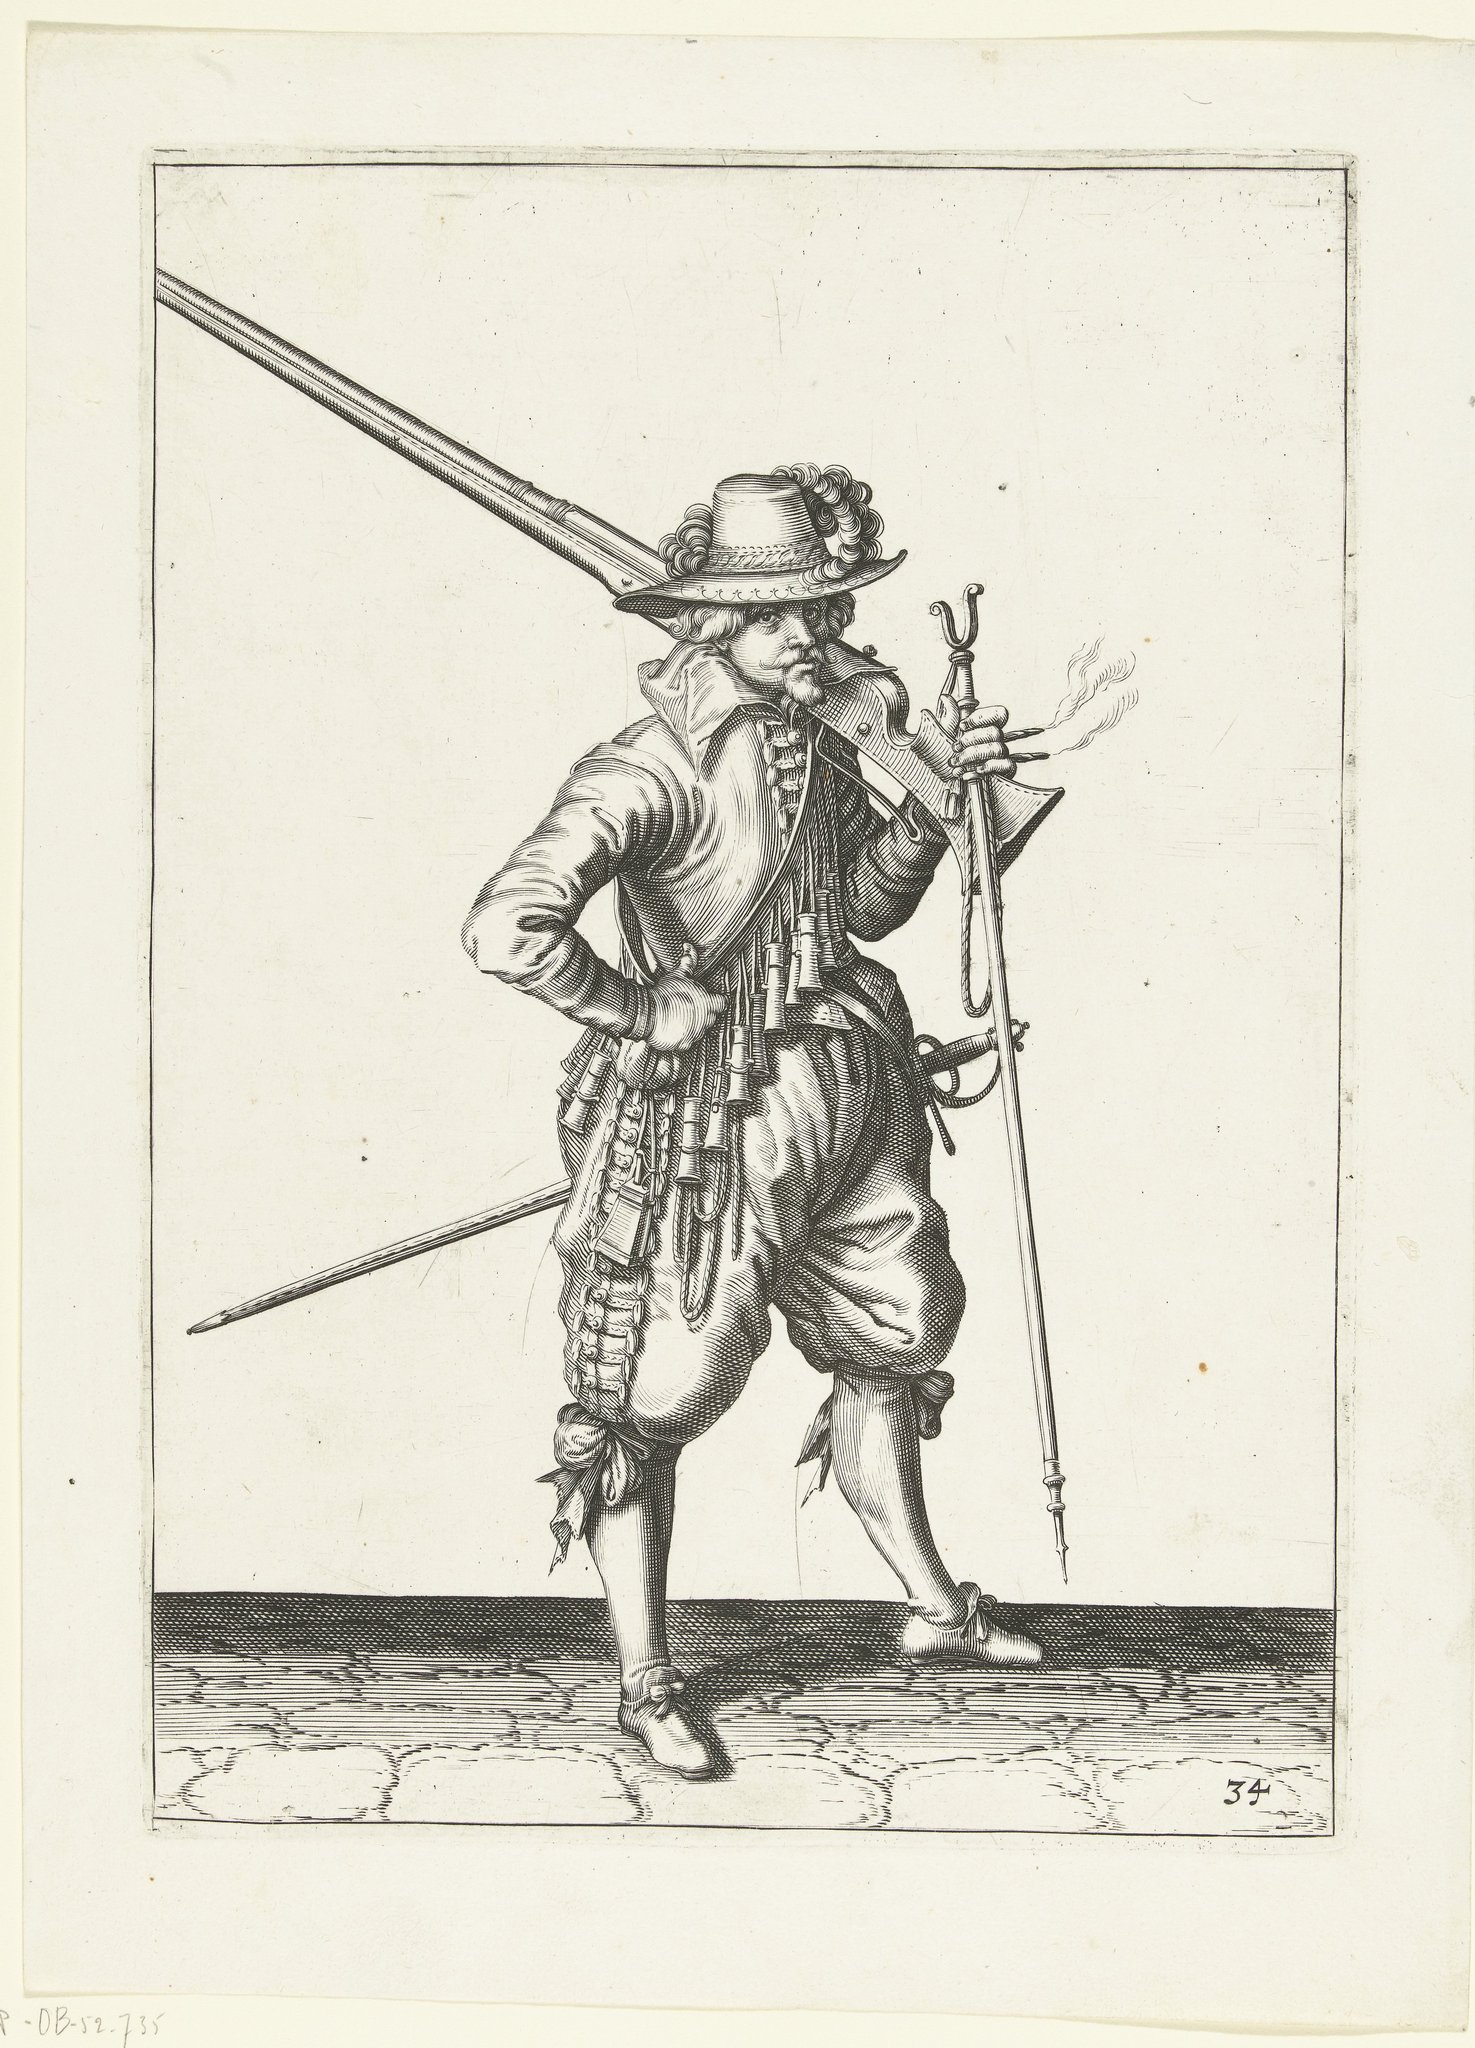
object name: print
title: Wapenhandelinghe van Roers Musquetten ende Spiessen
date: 1597-1607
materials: paper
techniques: engraving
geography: netherlands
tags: manoeuvre ~ military training, firearms: rifle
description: Een soldaat, ten voeten uit, naar rechts, met een musket (een bepaald type vuurwapen) steunend op zijn linkerschouder. In zijn linkerhand behalve de kolf van het musket ook een brandende lont en een furket (musketvork). Het gaat dus om (vrijwel) dezelfde positie als degene die op de tweede prent van de serie getoond wordt. Deze prent is onderdeel van de reeks van 43 genummerde prenten van musketiers uit de Wapenhandelinghe.